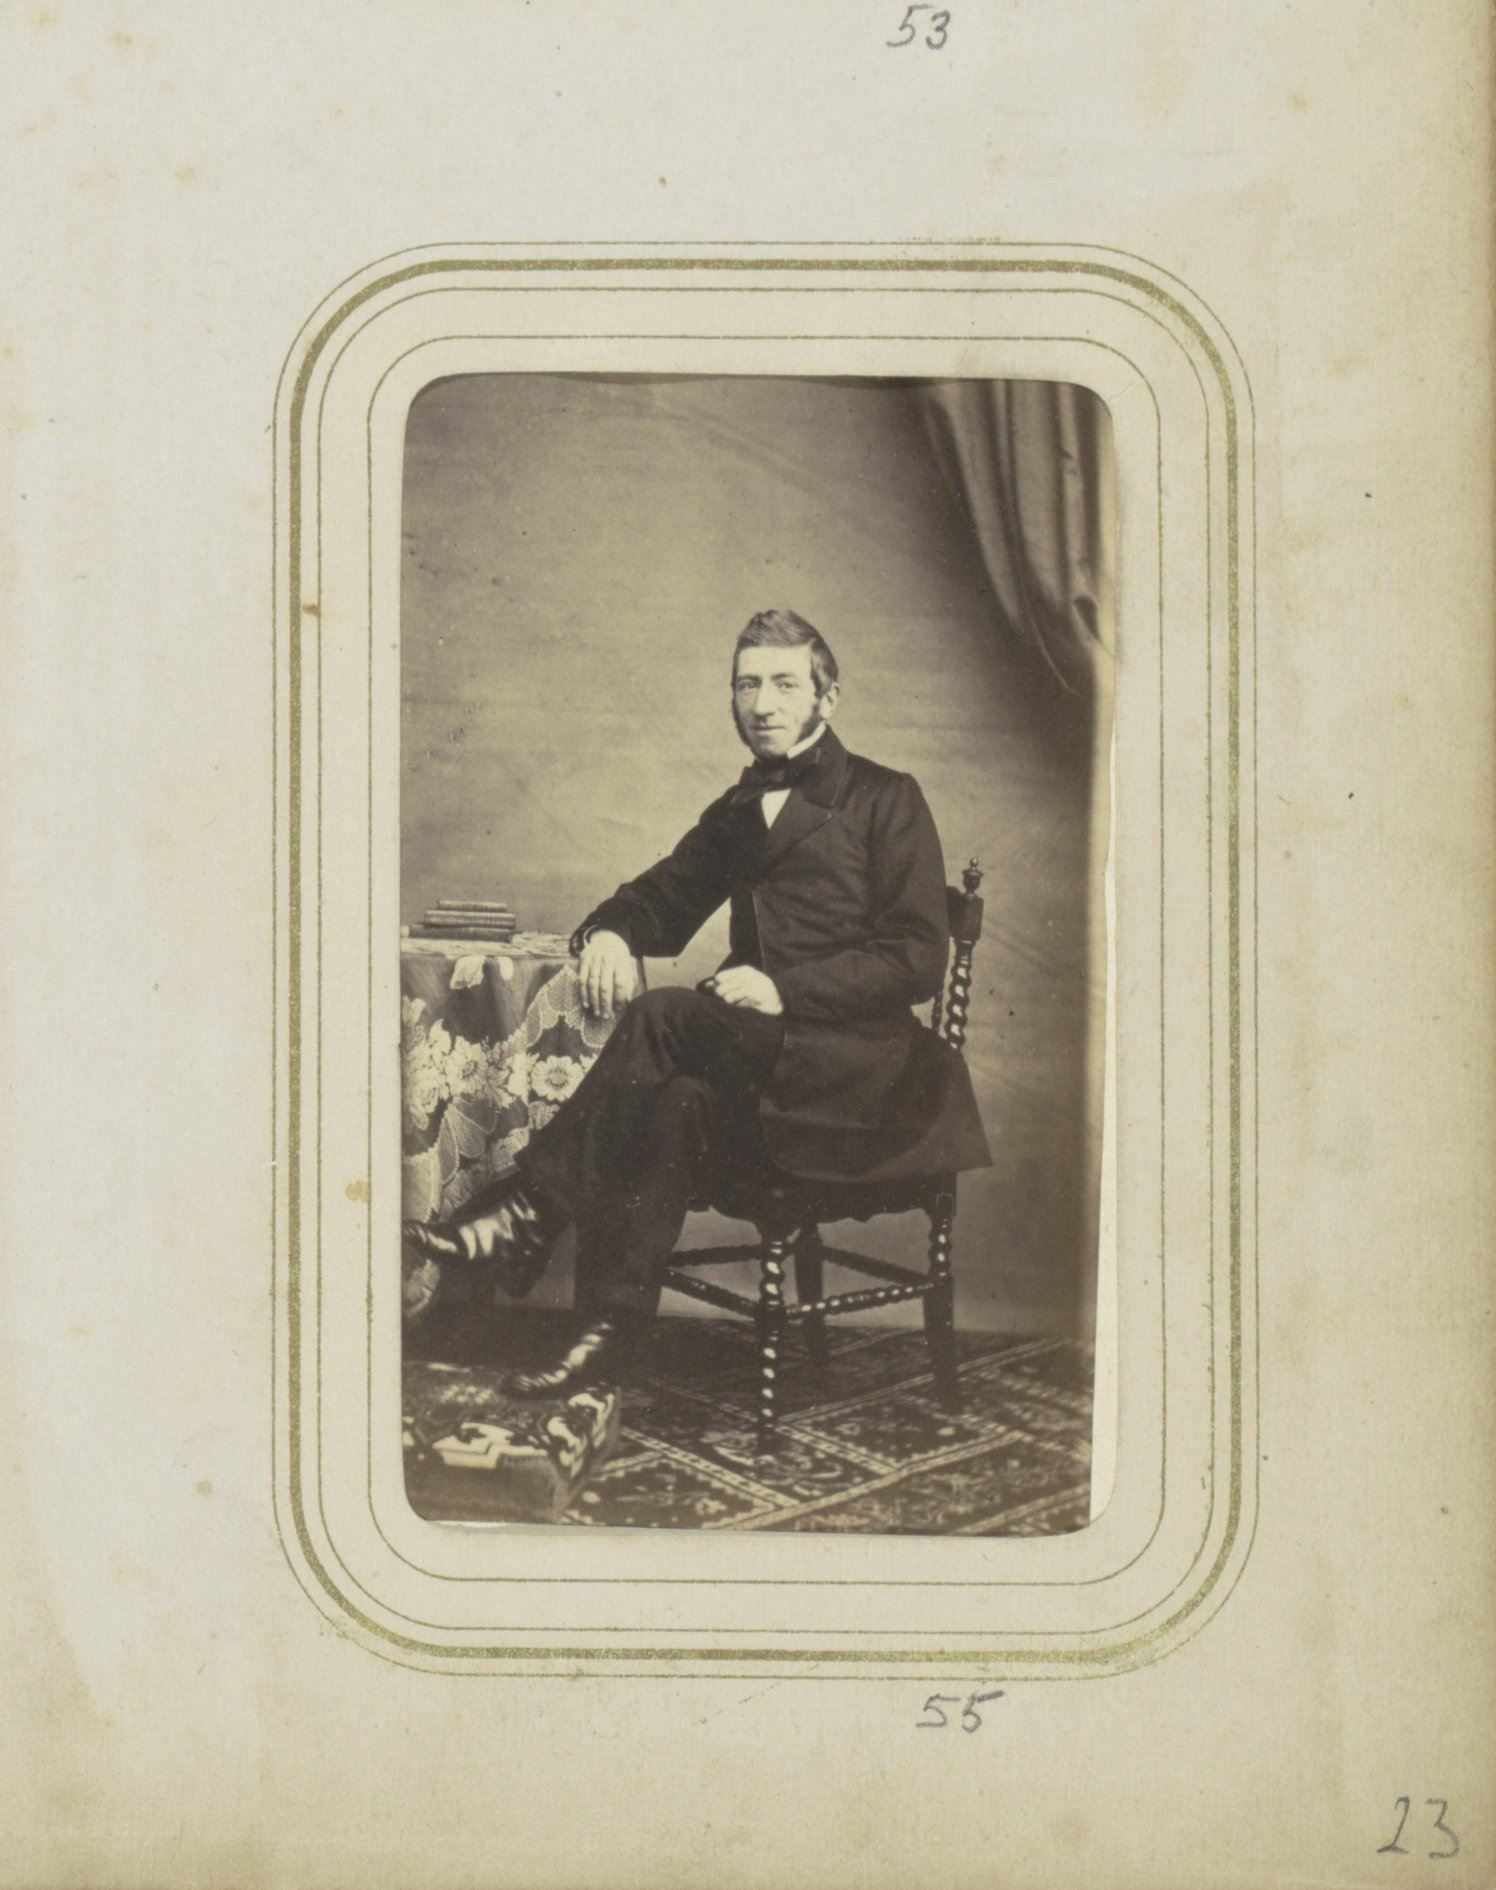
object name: carte de visite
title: Portret van een man met bakkebaarden in een lange jas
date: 1860-1880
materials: cardboard, photographic support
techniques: albumen print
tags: sideburns, studio requisites ~ photographer, trousers, breeches, historical persons, neck-gear ~ clothing, family, relationship, descent, shoes, sandals, hairdress, coat, cape, netherlands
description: Onderdeel van Familiealbum van H.W.F. Ligtenberg en L.M. Swart met 149 foto's en cartes-de-visite.